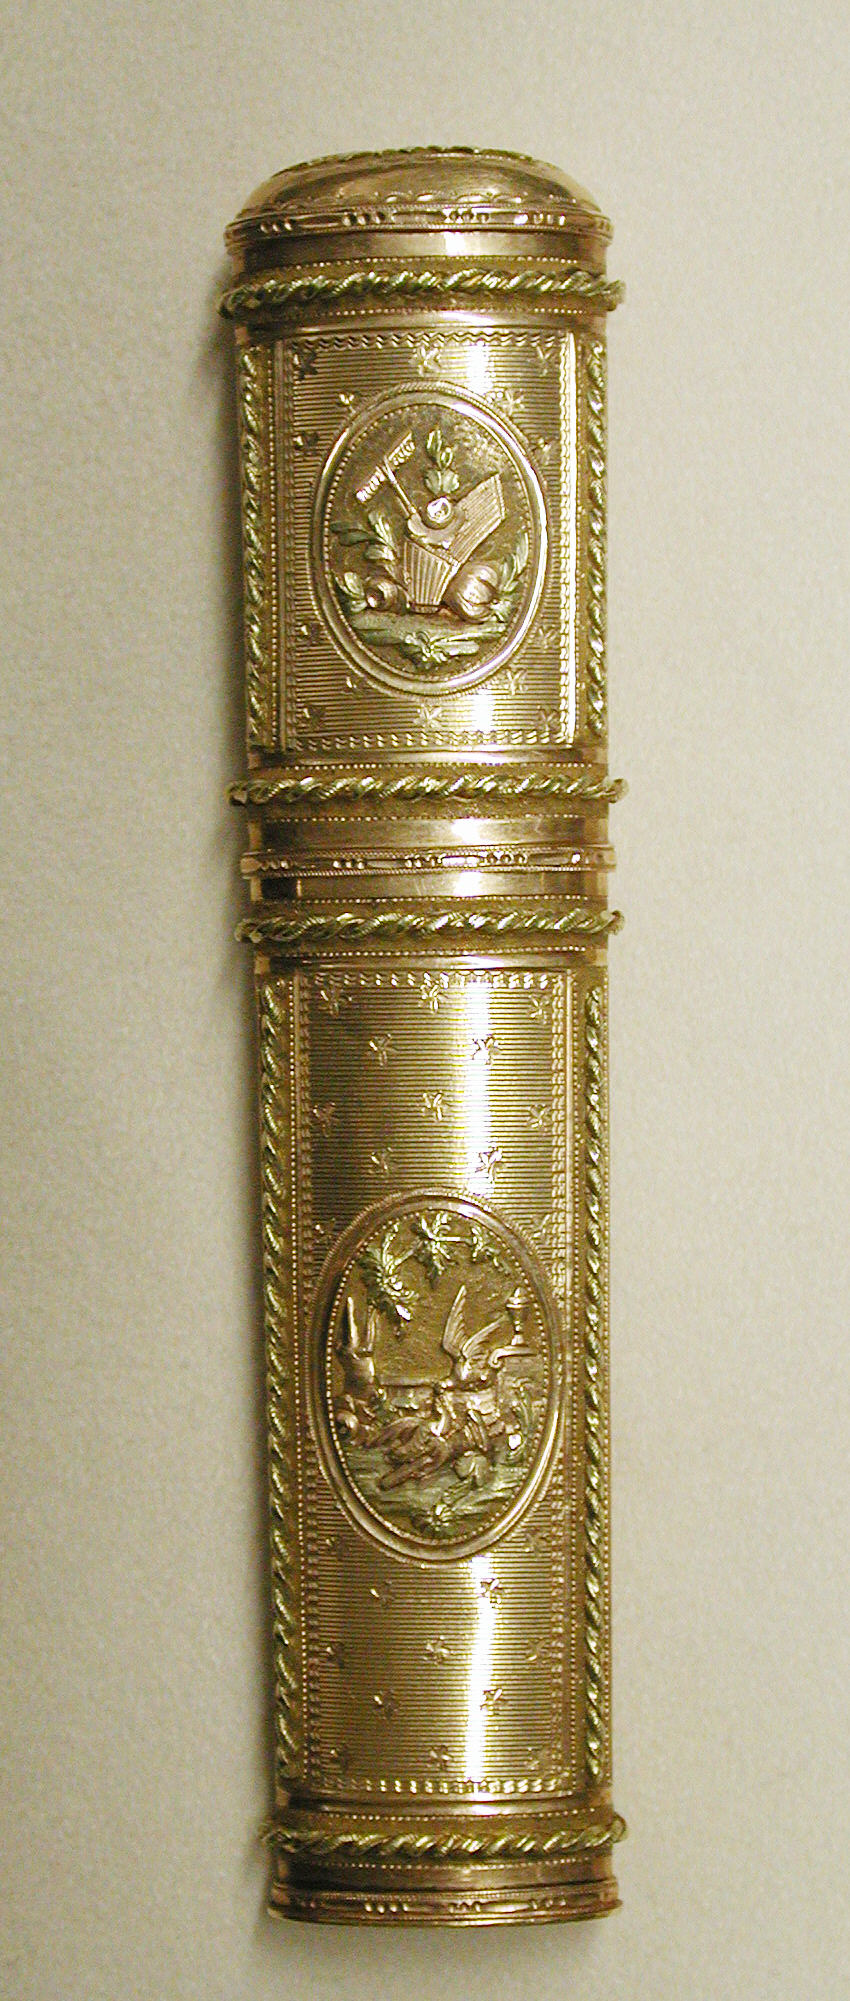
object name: étui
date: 1781-1782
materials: gold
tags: birds